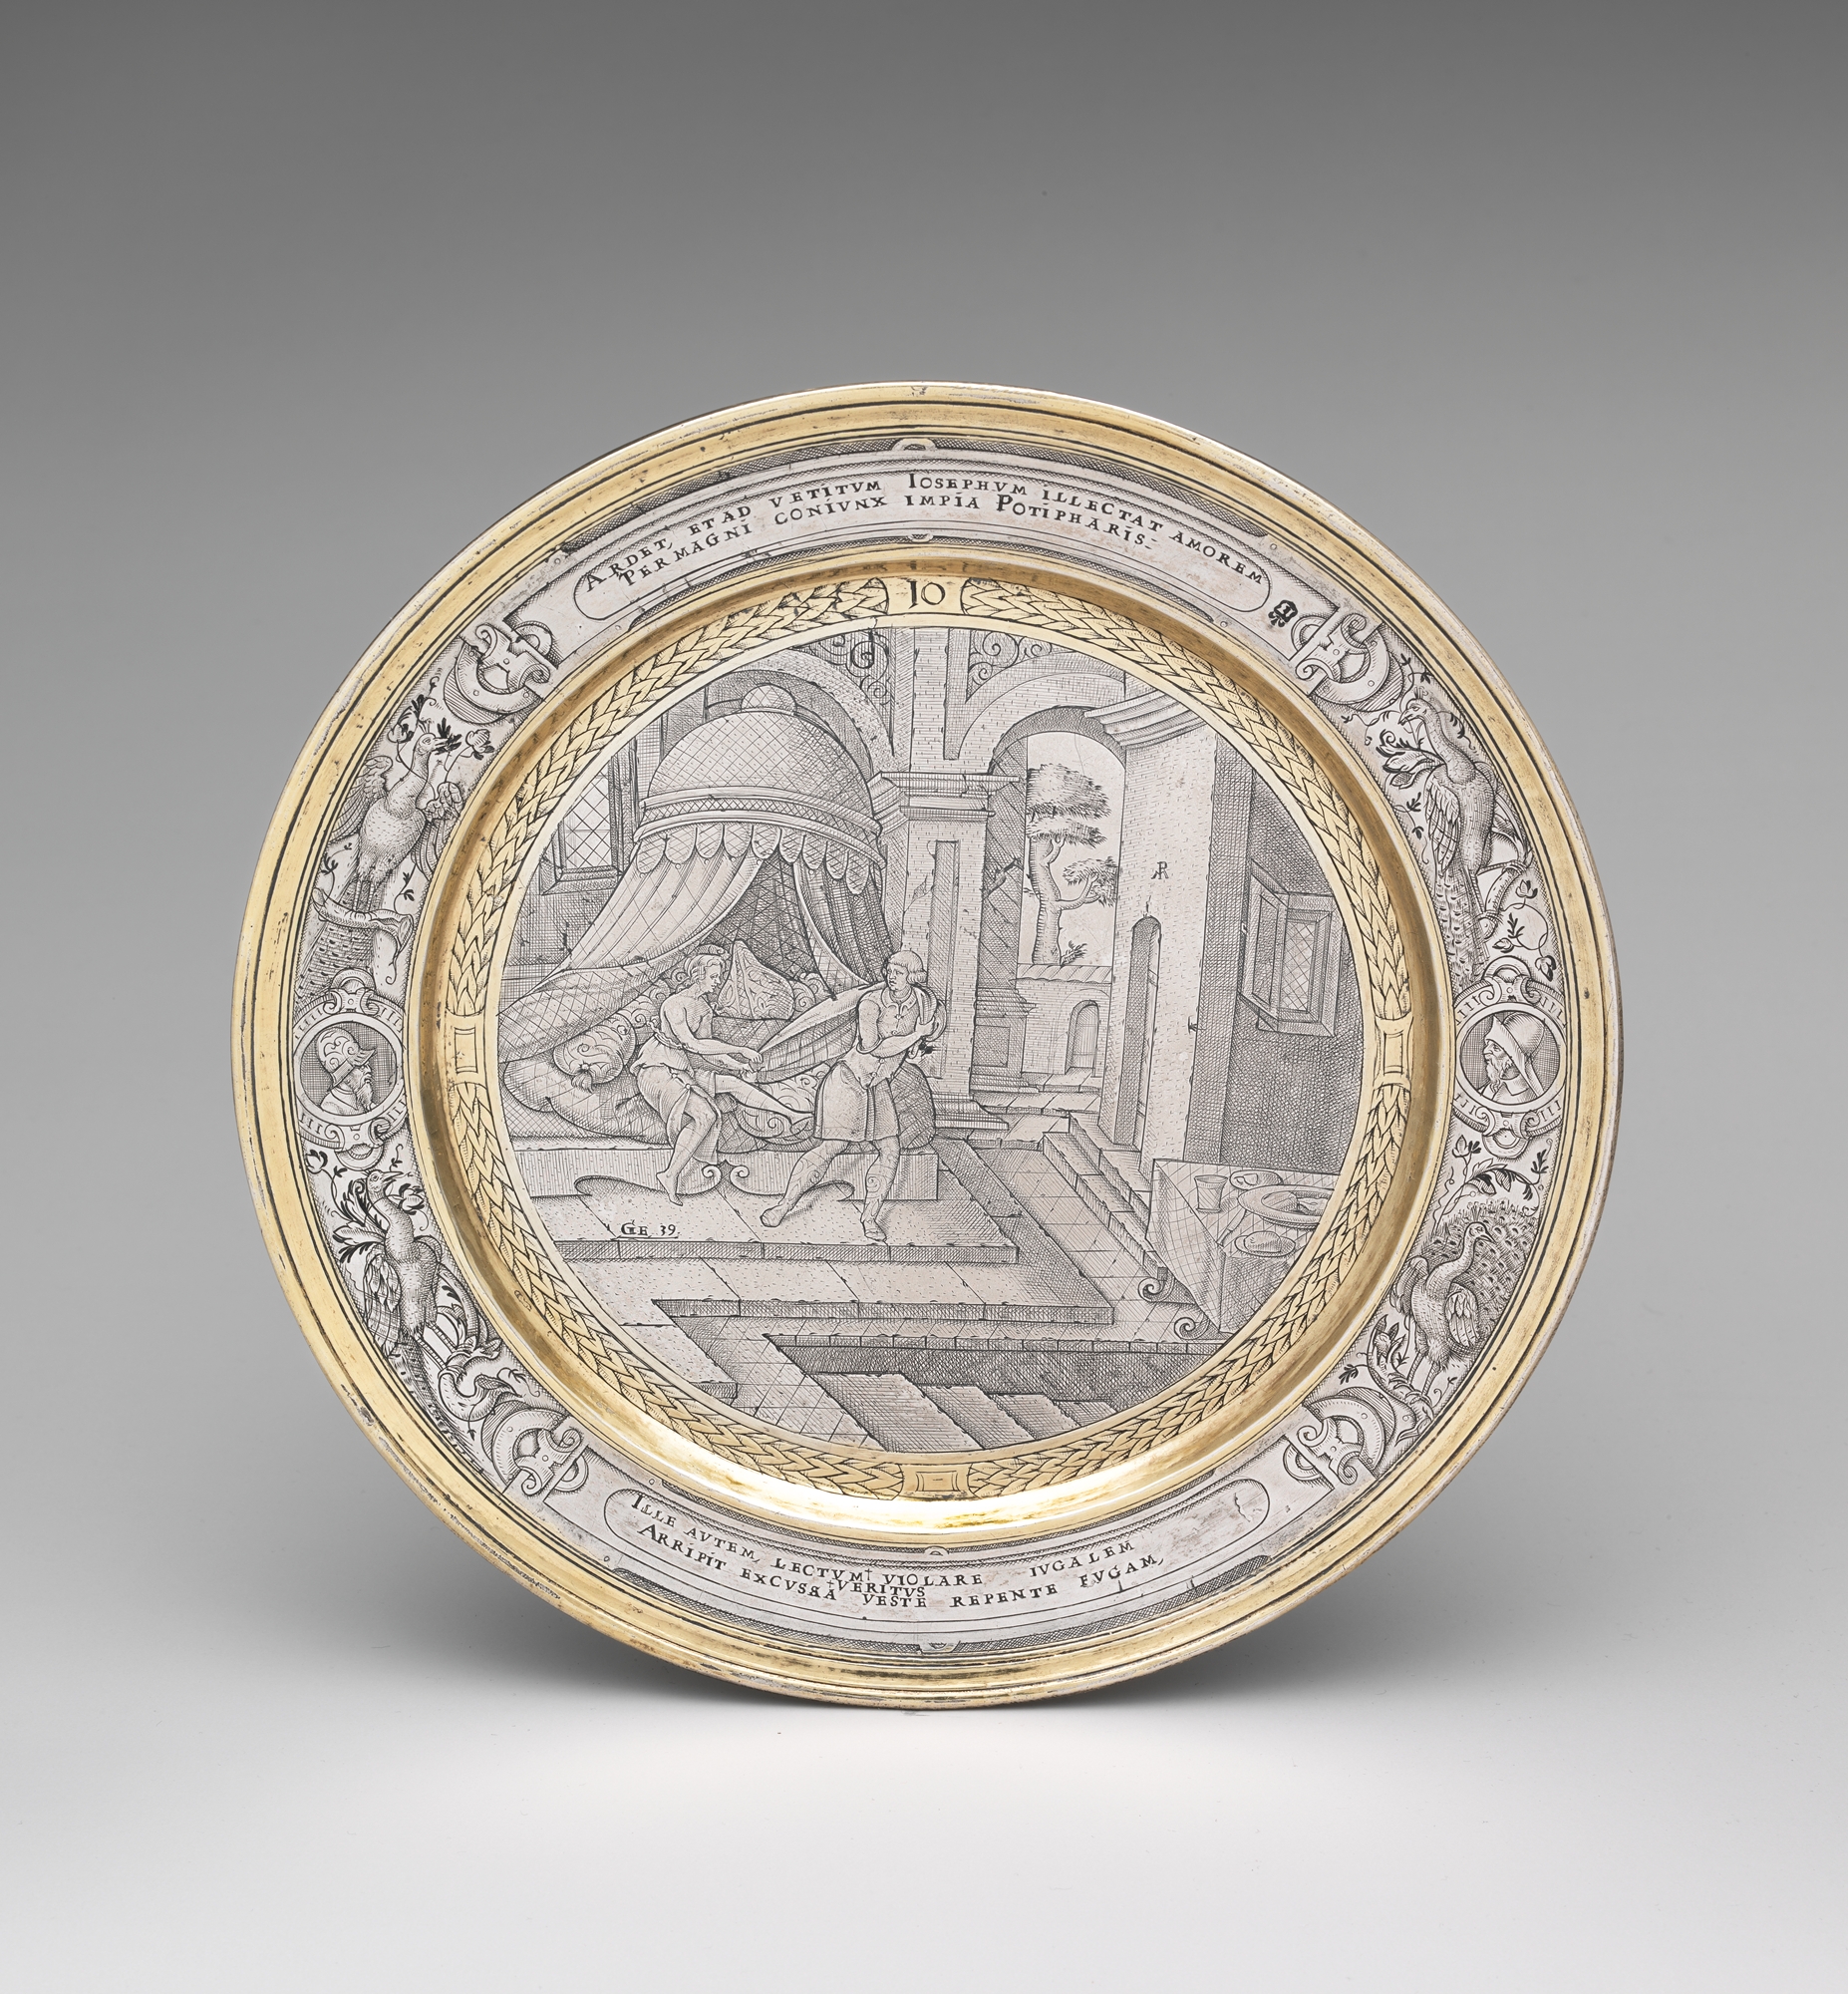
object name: plate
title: Joseph and Potiphar's wife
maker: p.m.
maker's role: engraver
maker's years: 1500-1600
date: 1567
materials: silver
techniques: gilding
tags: men,women,peacocks